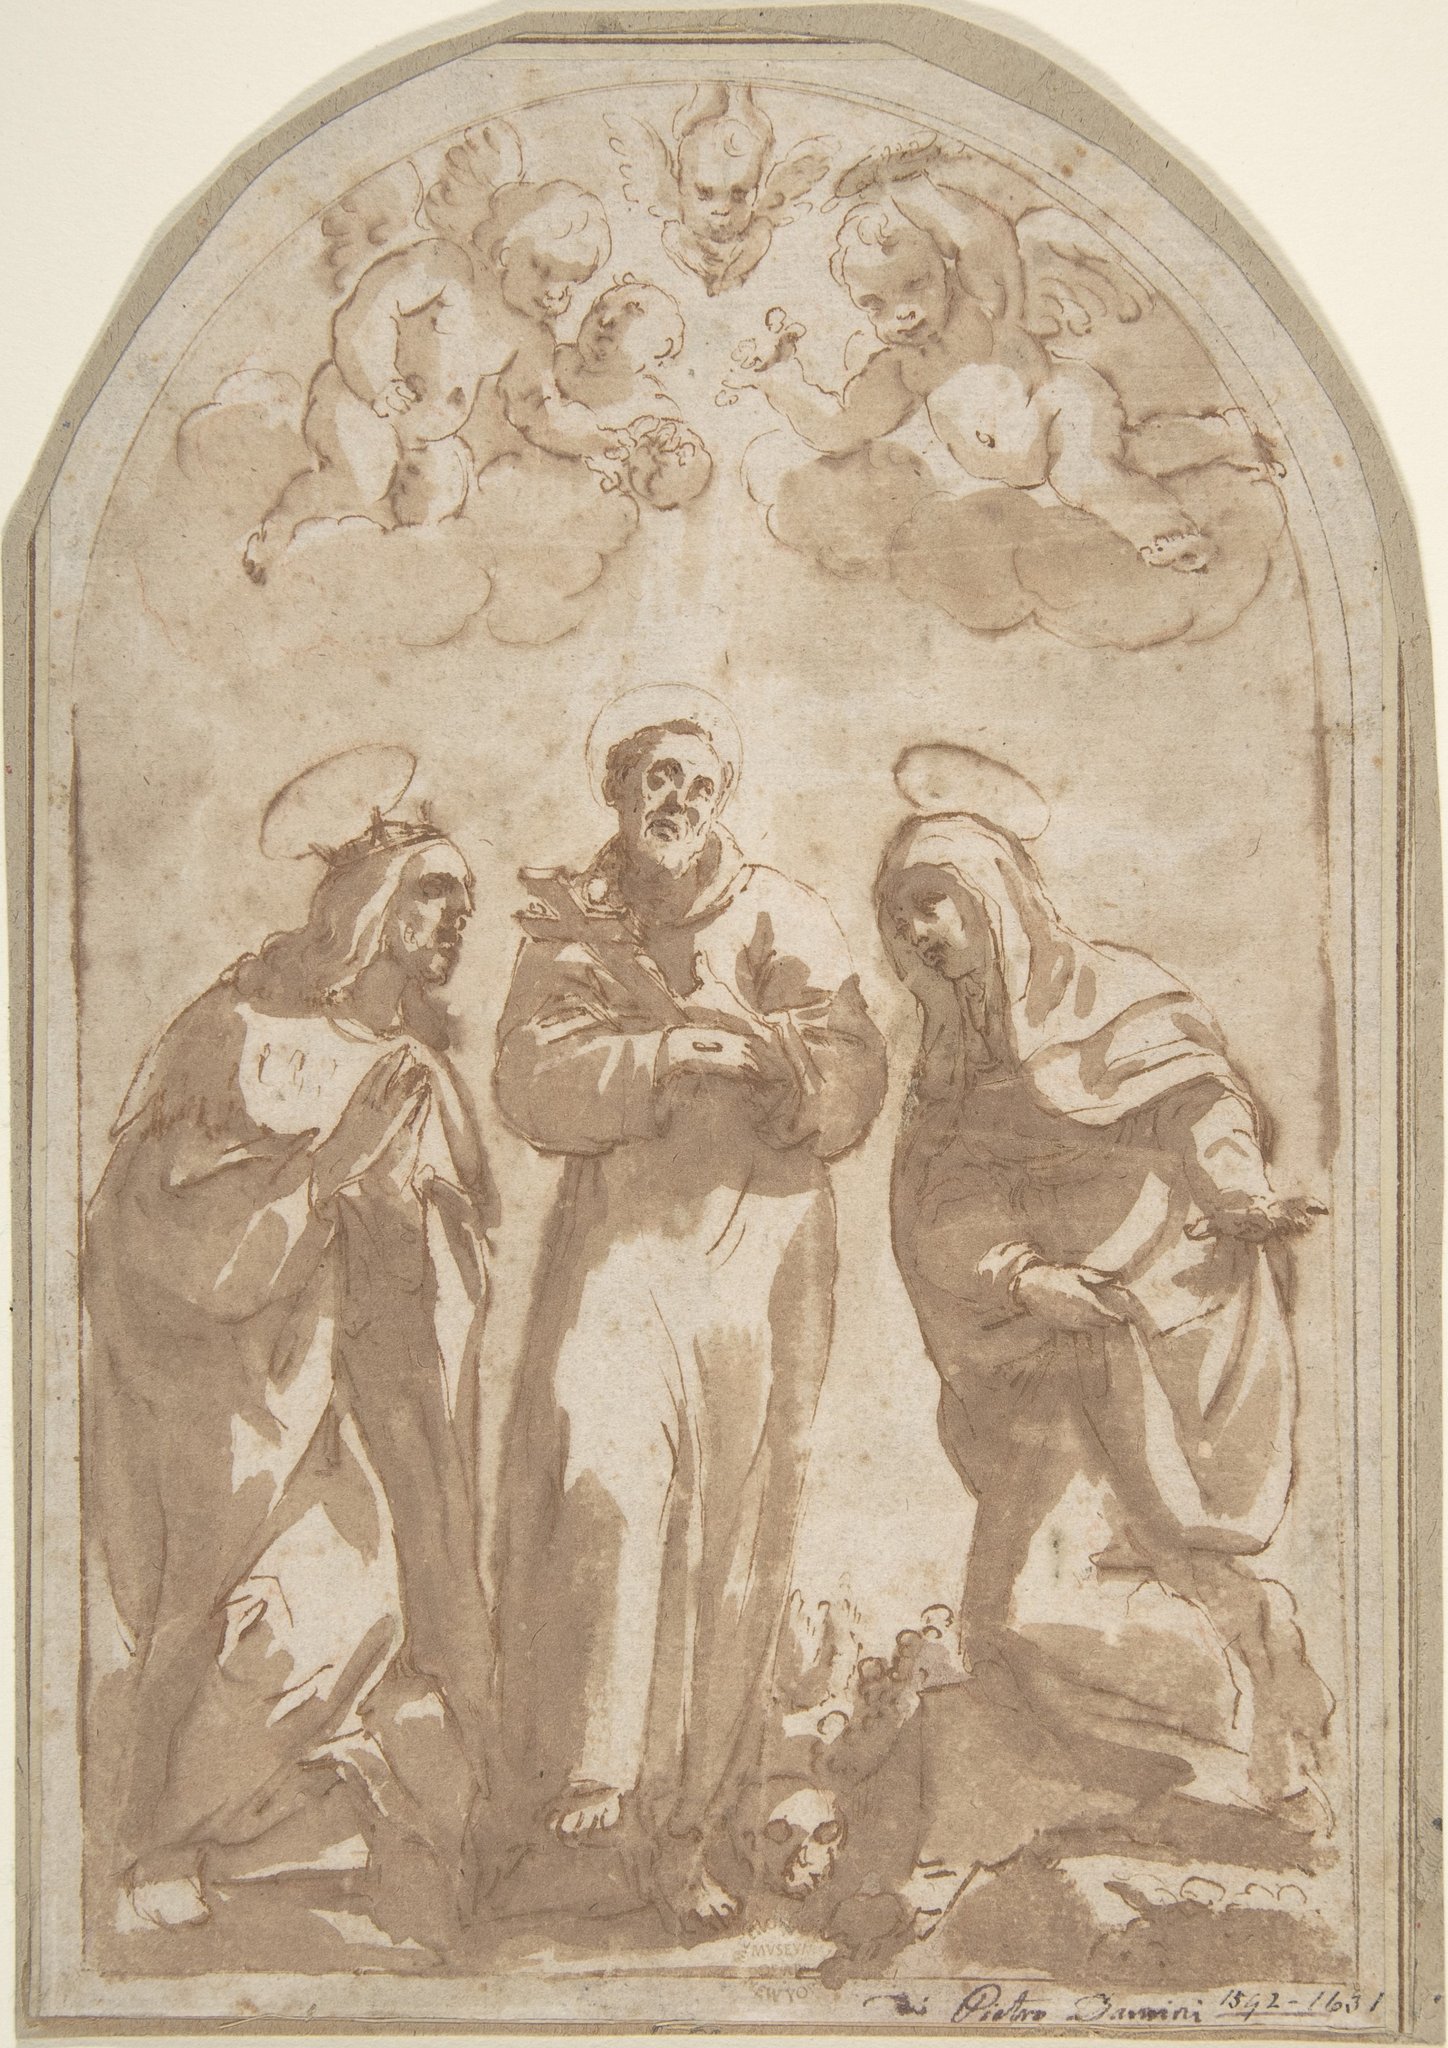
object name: drawing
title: Saint Louis of France, Saint Francis, and a Female Monastic Saint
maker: pietro damini (pietro damini da castelfranco)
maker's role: artist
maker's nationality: italian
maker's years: 1592-1631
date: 1592-1631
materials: ink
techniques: brush, pen, wash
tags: saint francis,saints